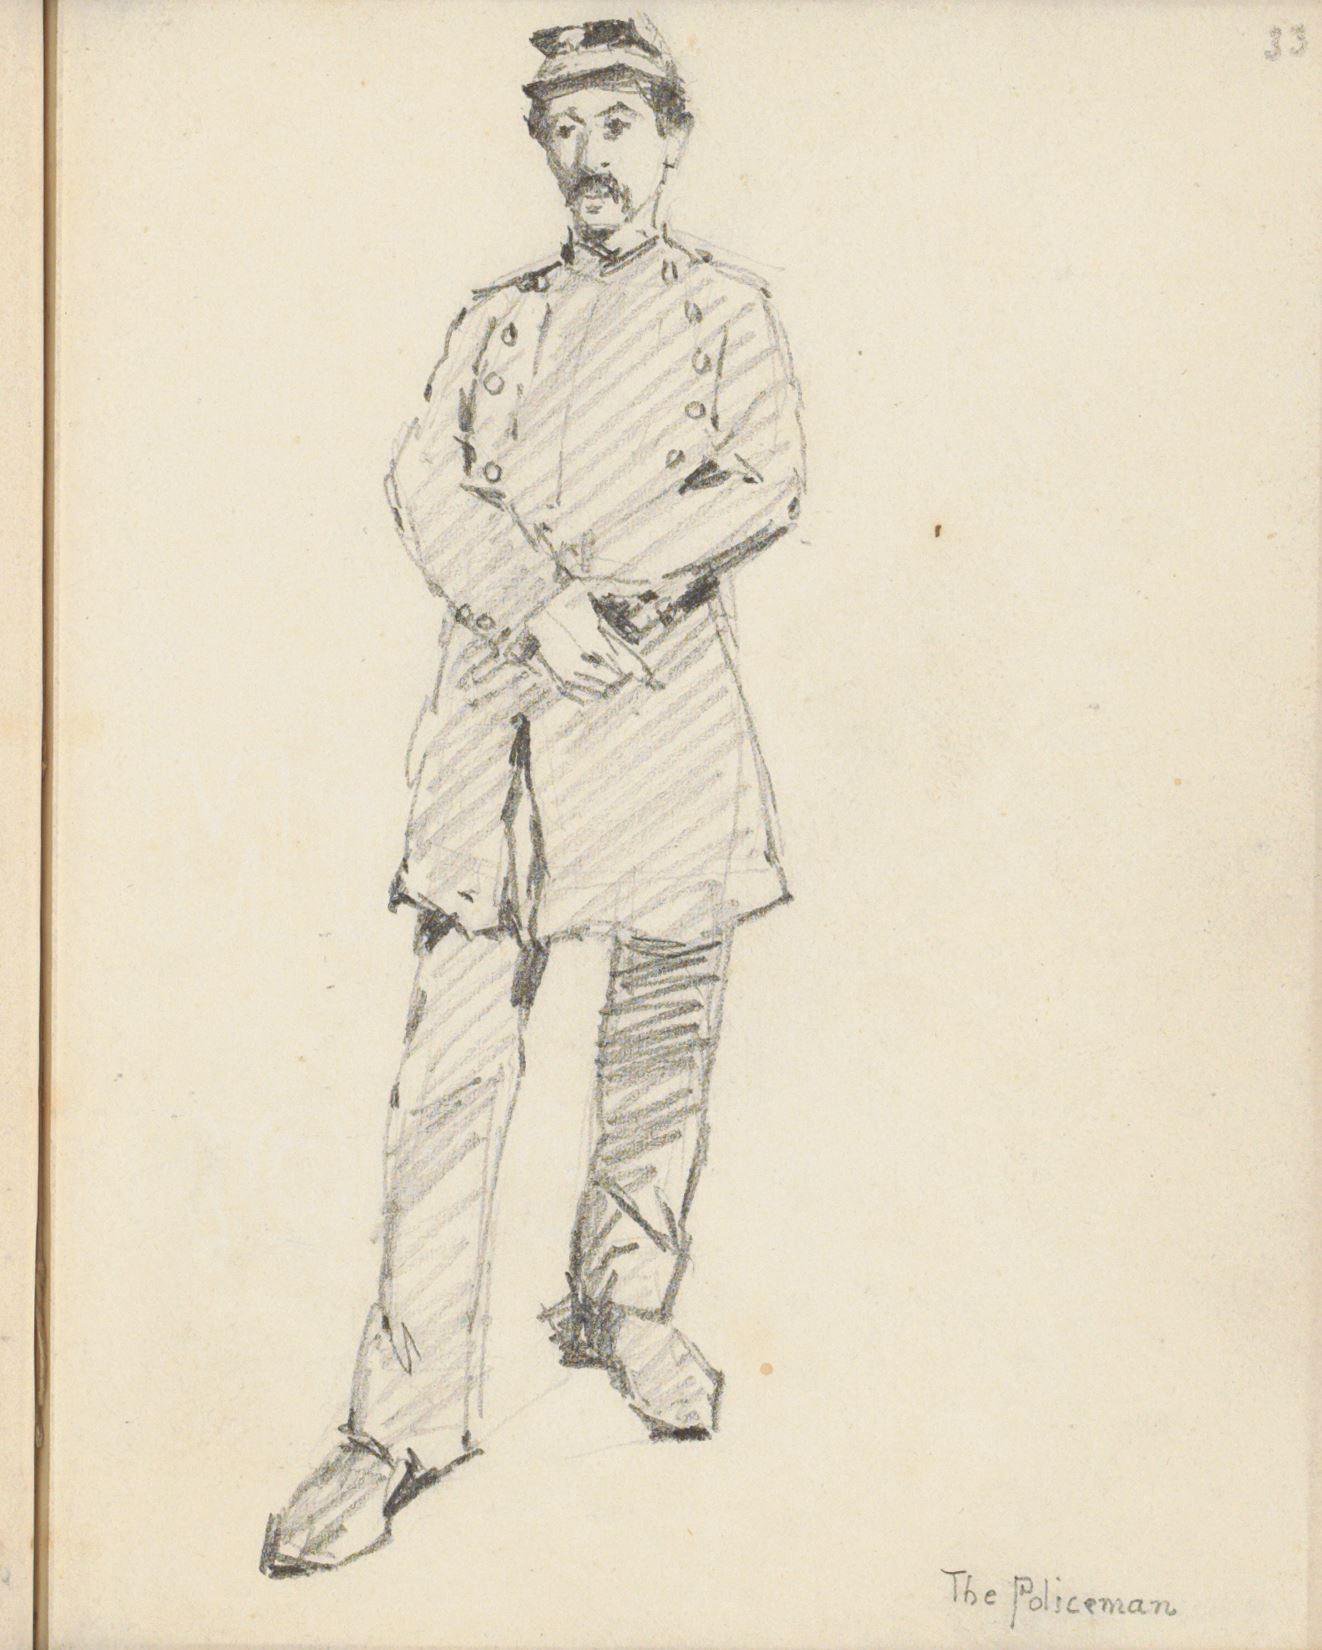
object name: sketchbook leaf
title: Politieman uit Monnickendam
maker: alfred william rich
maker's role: draughtsman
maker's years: 1856-1921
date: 1892-1893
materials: paper, pencil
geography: monnickendam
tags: policeman, constable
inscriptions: annotation: ‘The Policeman’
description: Blad 33 recto uit een schetsboek met 86 bladen.